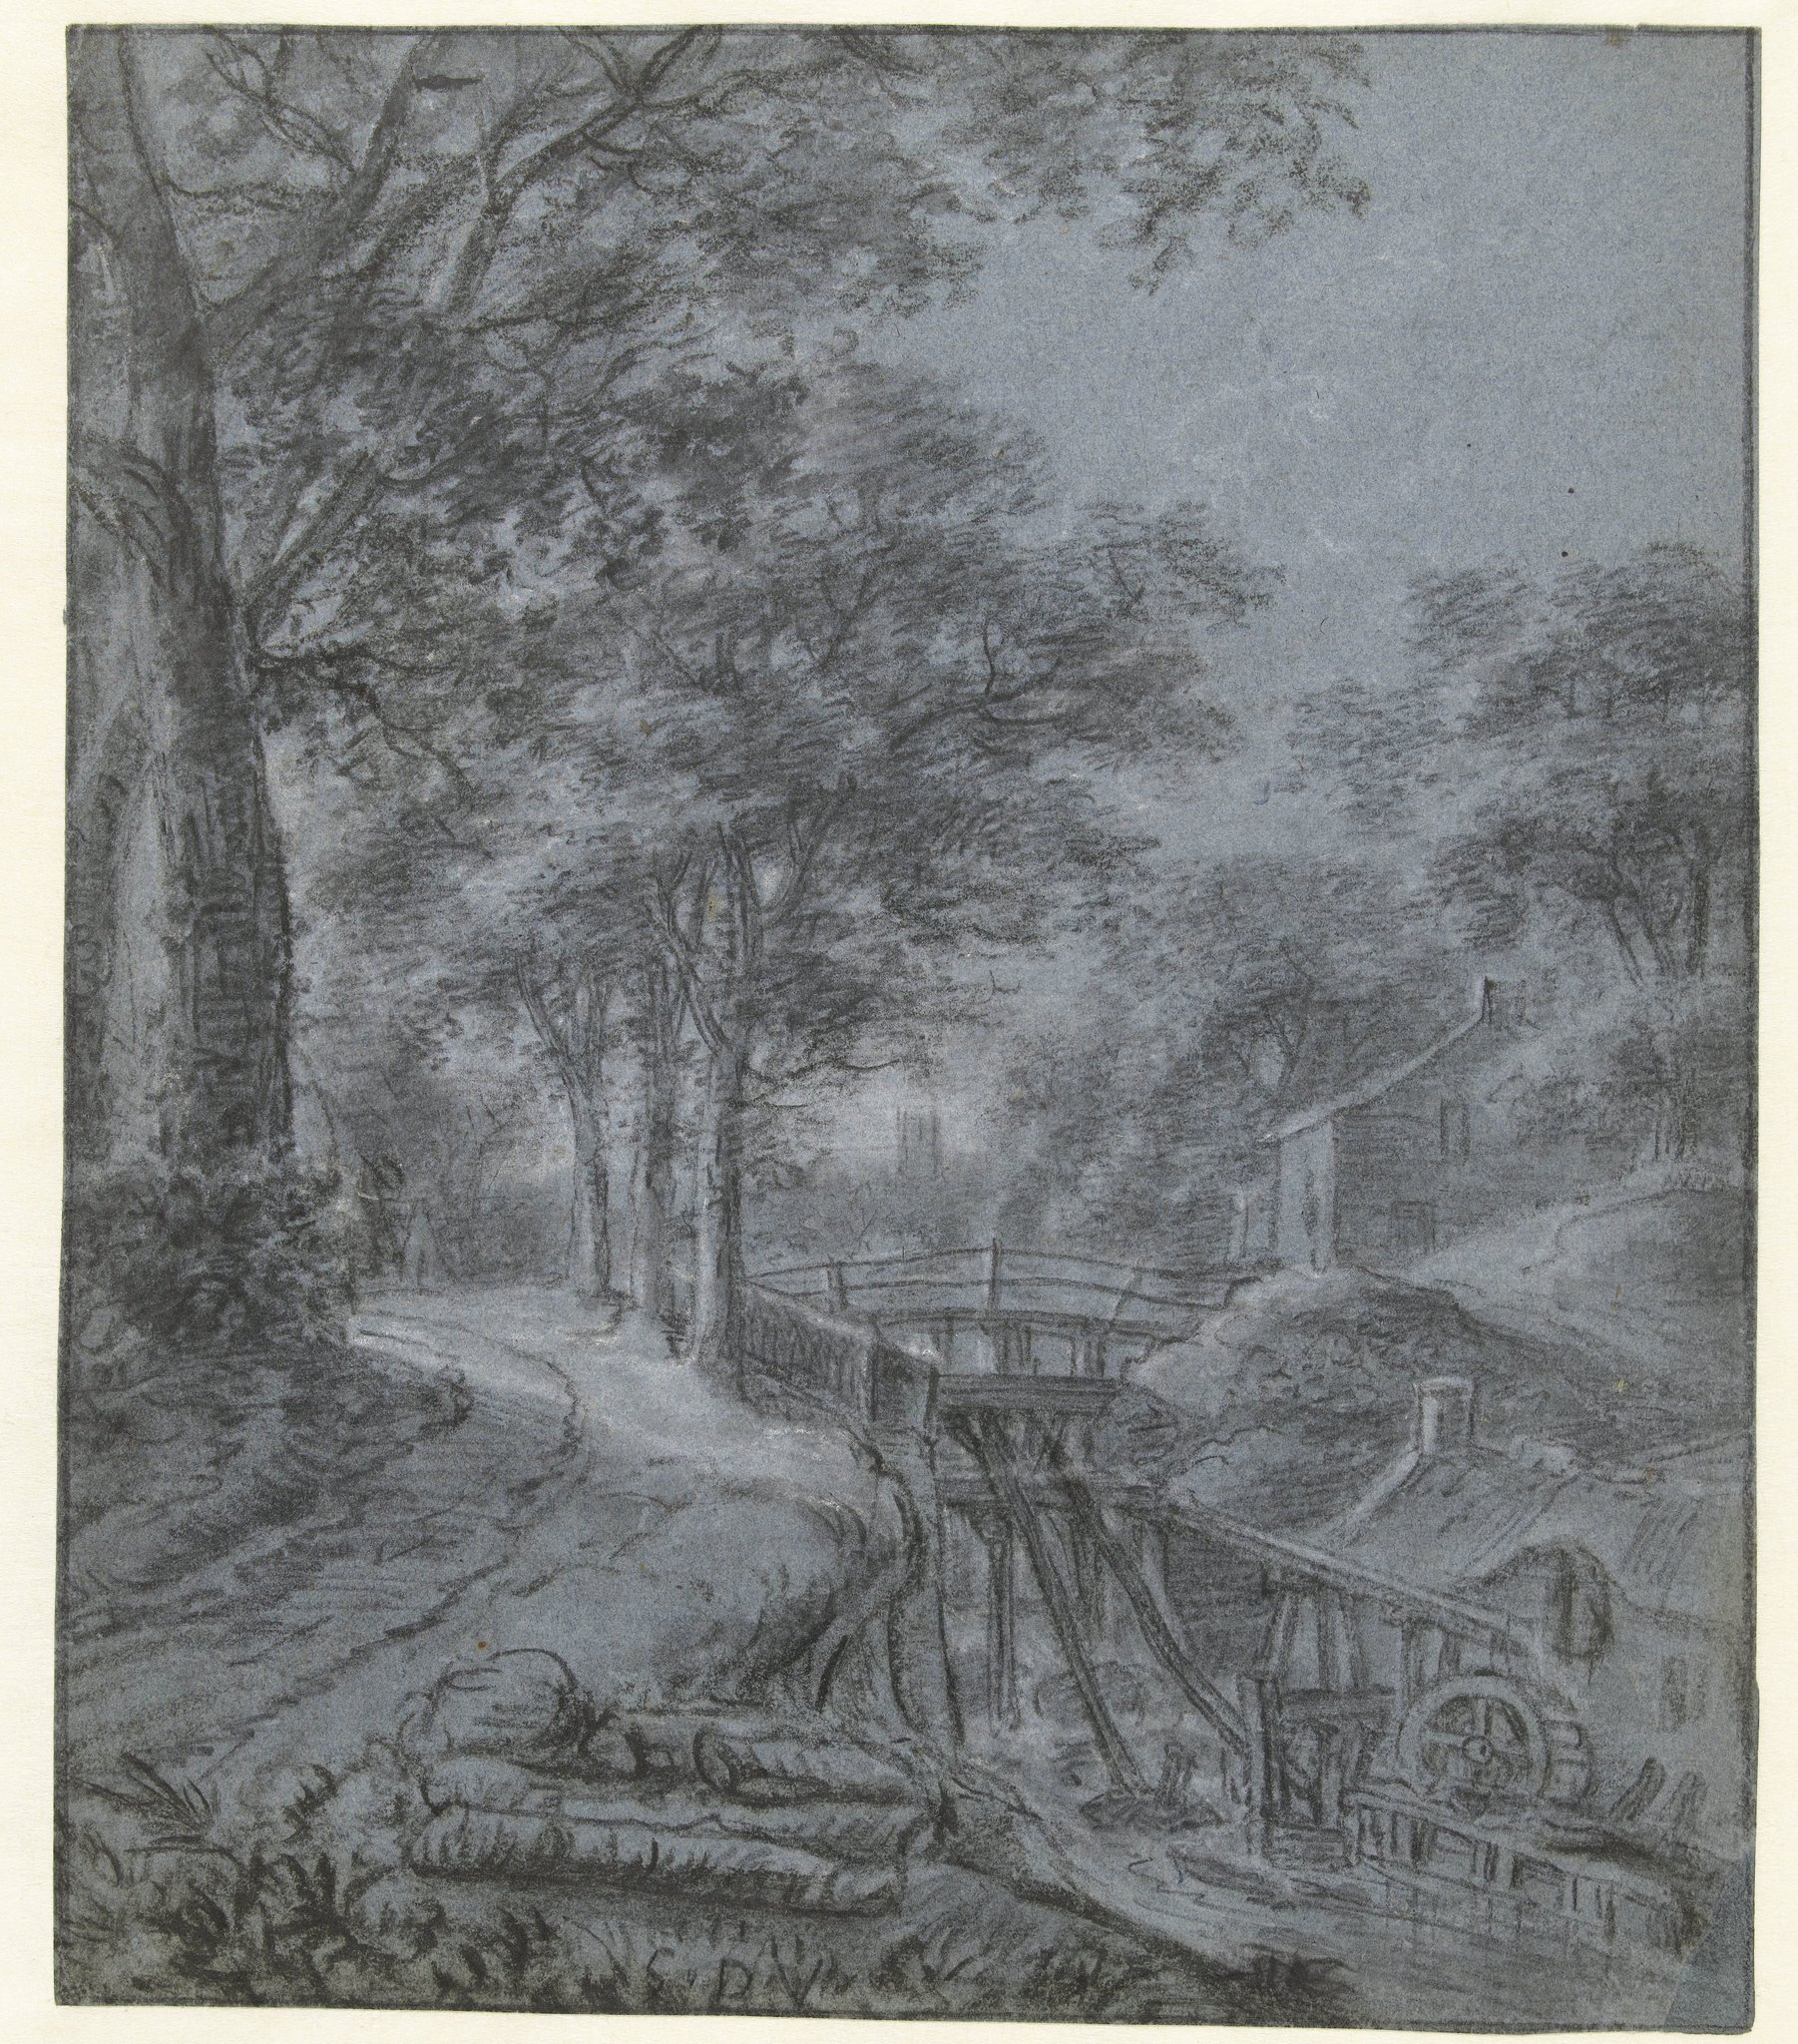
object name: drawing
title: Watermolen in een heuvelachtig landschap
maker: simon de vlieger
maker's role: draughtsman, painter, print maker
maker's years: 1600-1653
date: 1610-1653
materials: chalk, charcoal, paper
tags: low hill country, watermill in landscape